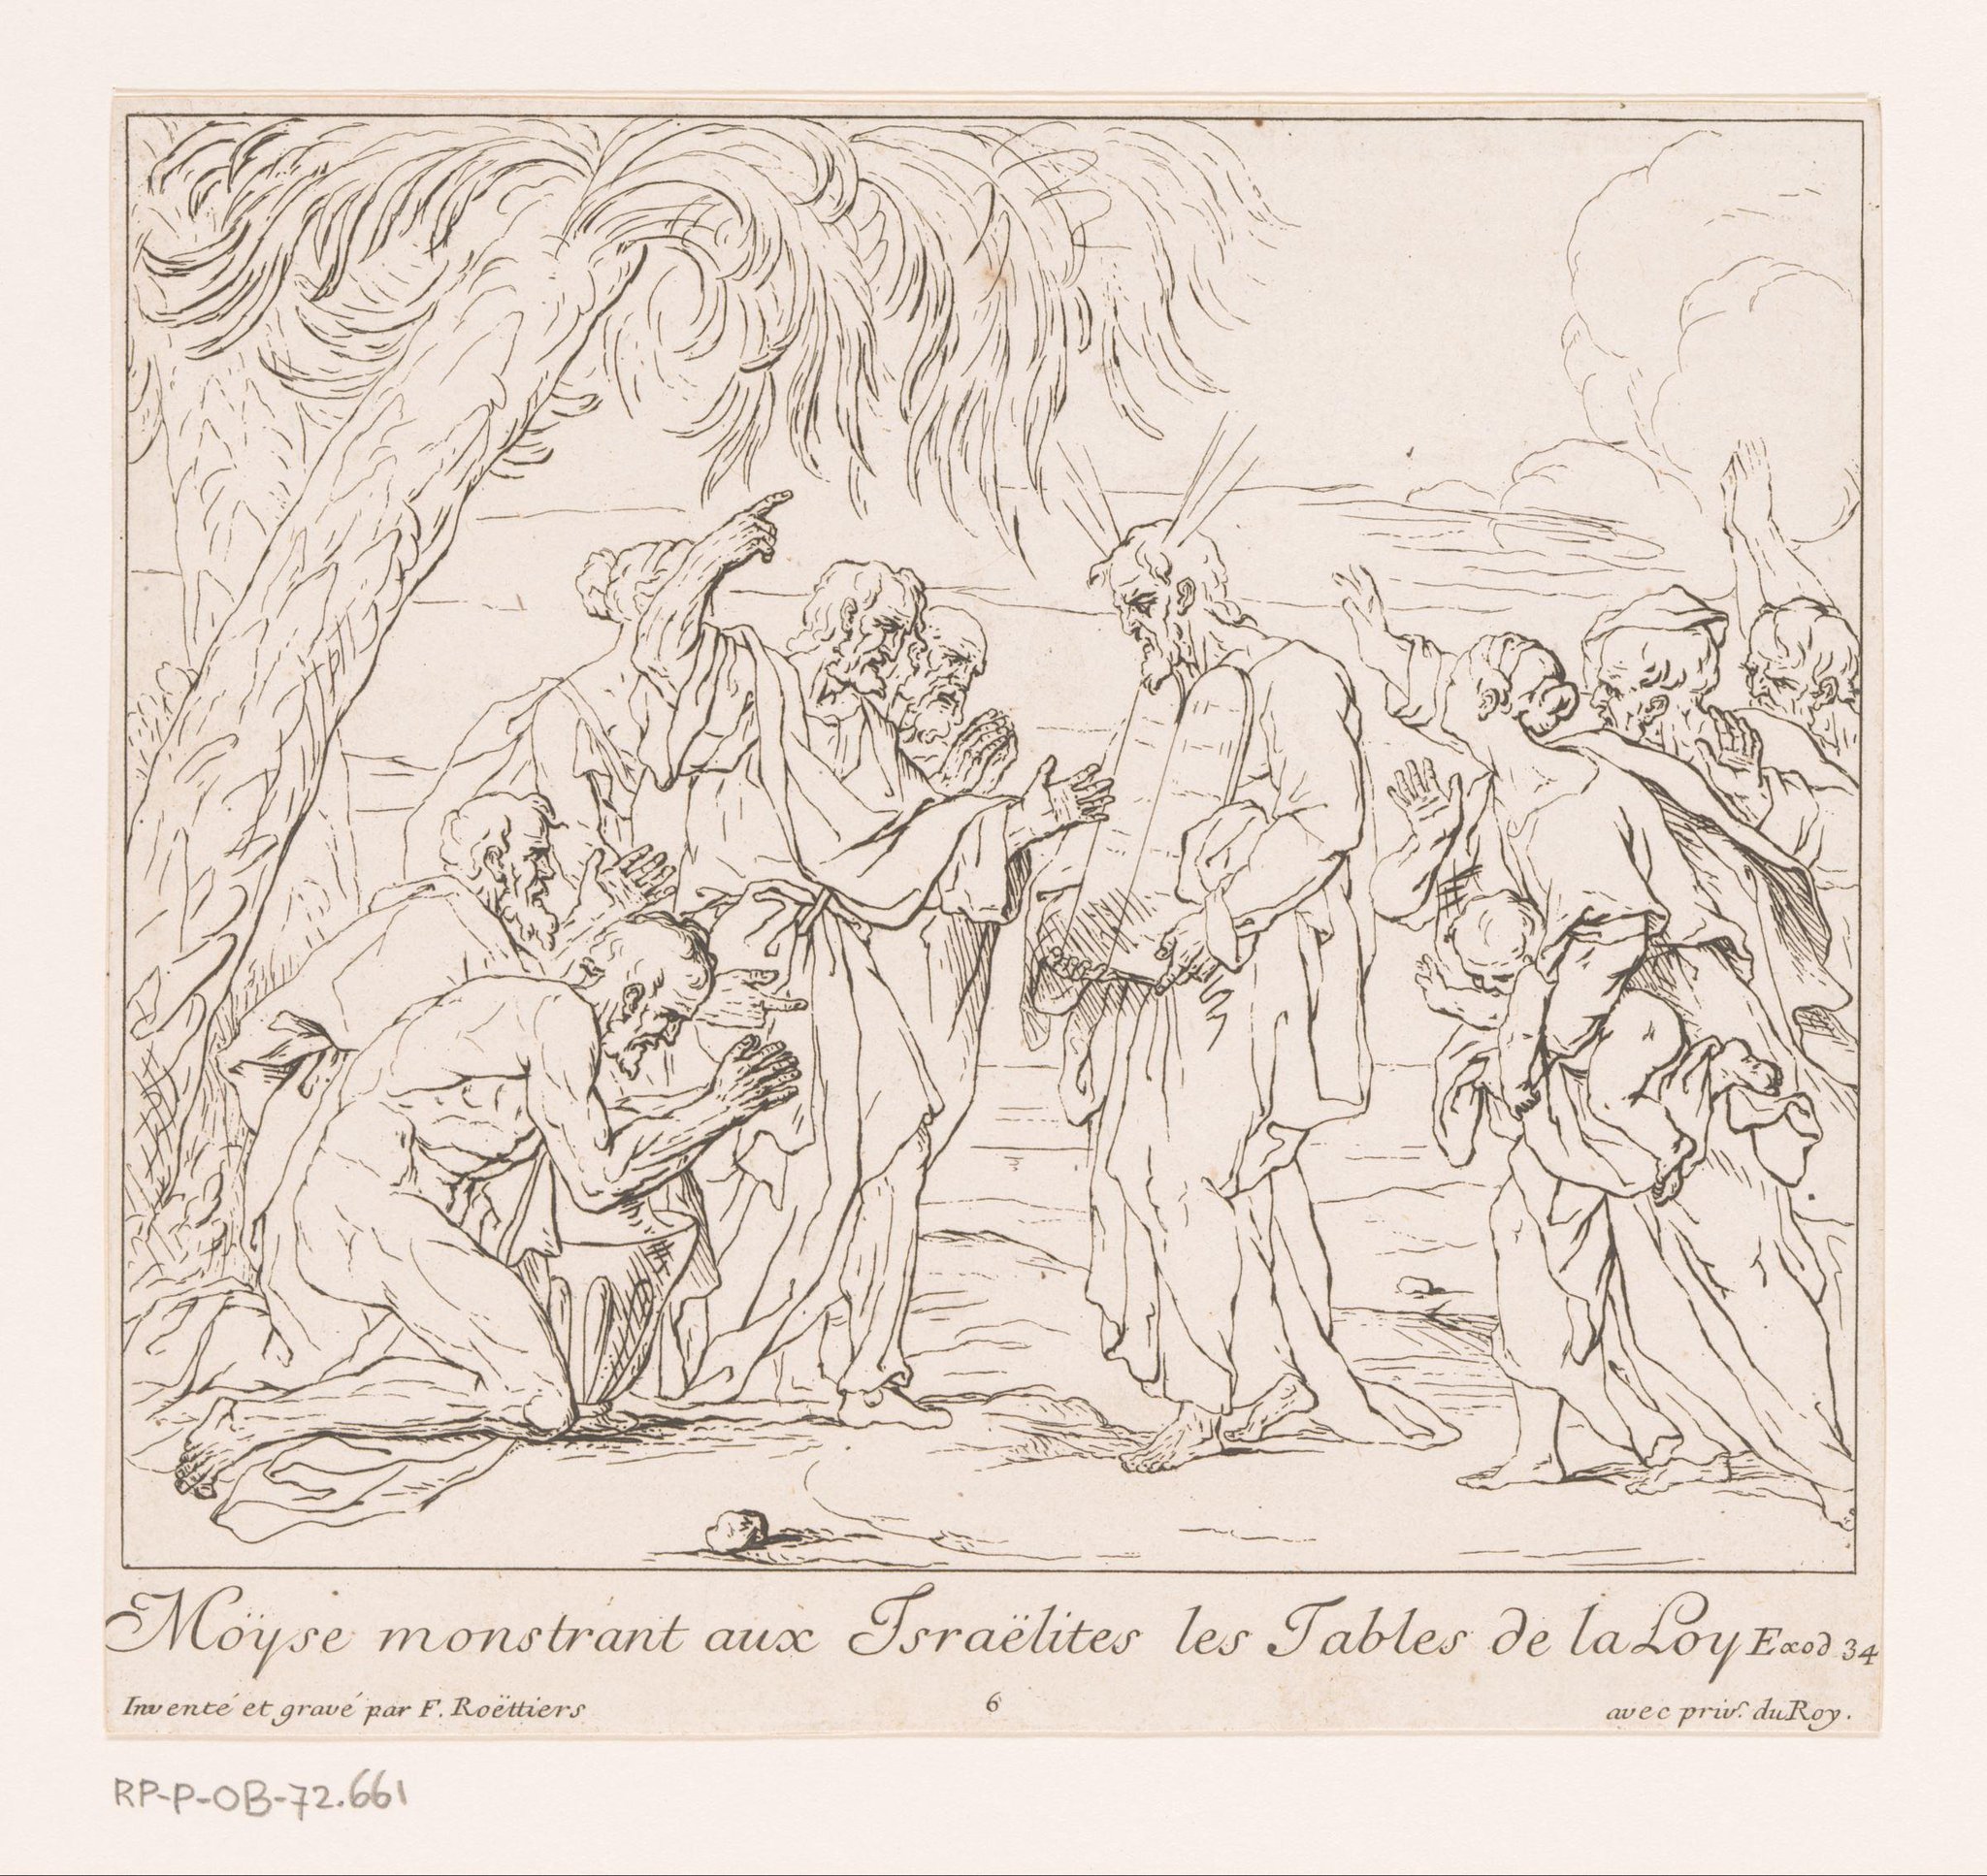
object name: print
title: Moyse monstrant aux Israëlites les Tables de la Loy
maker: françois roëttiers (i)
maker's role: print maker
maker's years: 1685-1743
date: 1695-1742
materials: paper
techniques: etching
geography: france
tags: moses comes down with the new tablets and is awaited by aaron and the assembled people, who notice that 'his face is shining' (moses' face is depicted with rays of light or with horns)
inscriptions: collector's mark: Lugt 240